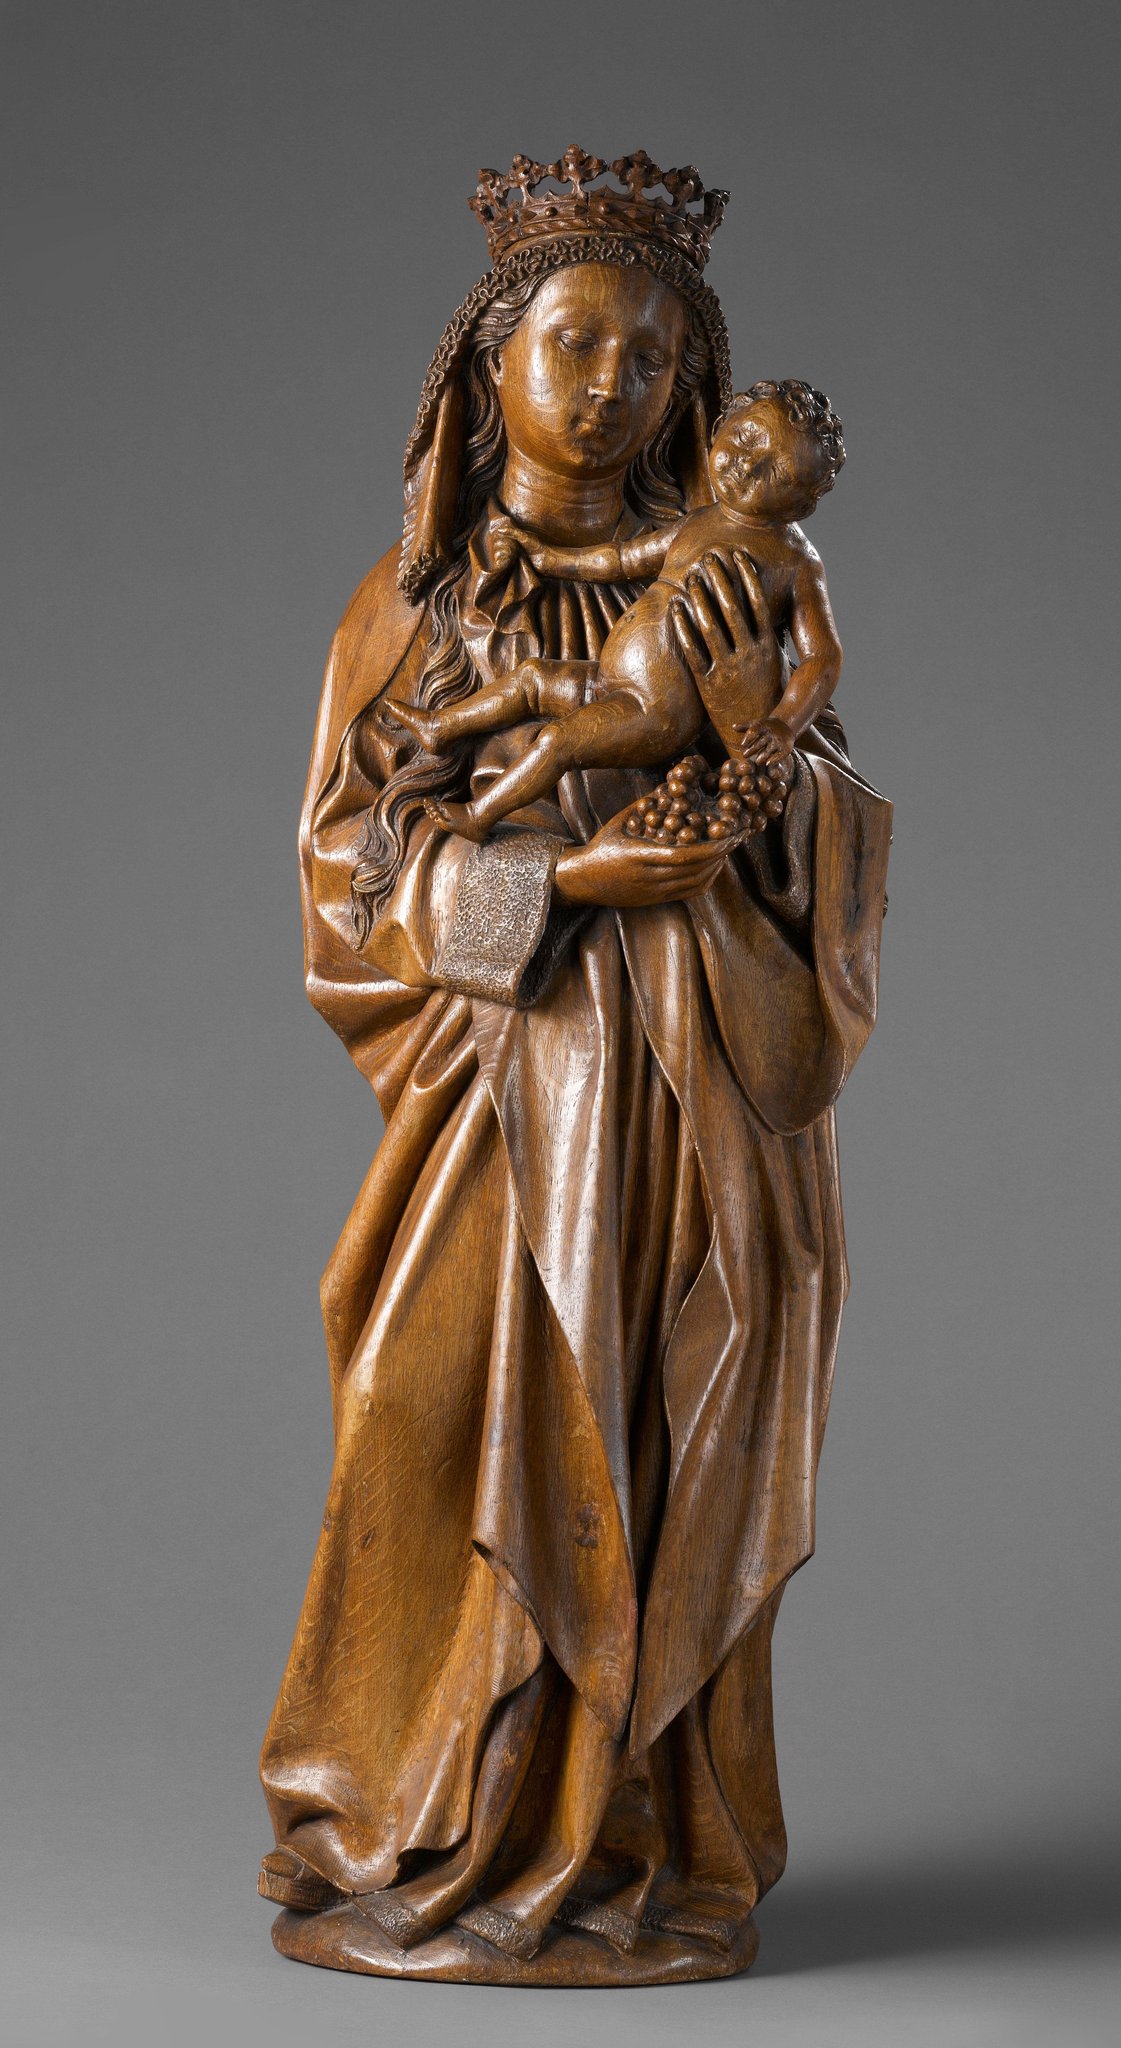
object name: sculpture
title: Virgin and Child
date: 1470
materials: wood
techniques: carved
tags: mary standing (or half-length), the christ-child in front of her, close to her bosom, bunch of grapes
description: The Virgin shown standing with the Christ Child on her arm was a universal theme in medieval religious art. Here she holds a bunch of grapes in her hand; they allude to wine, the symbol of the blood of Christ’s later suffering.